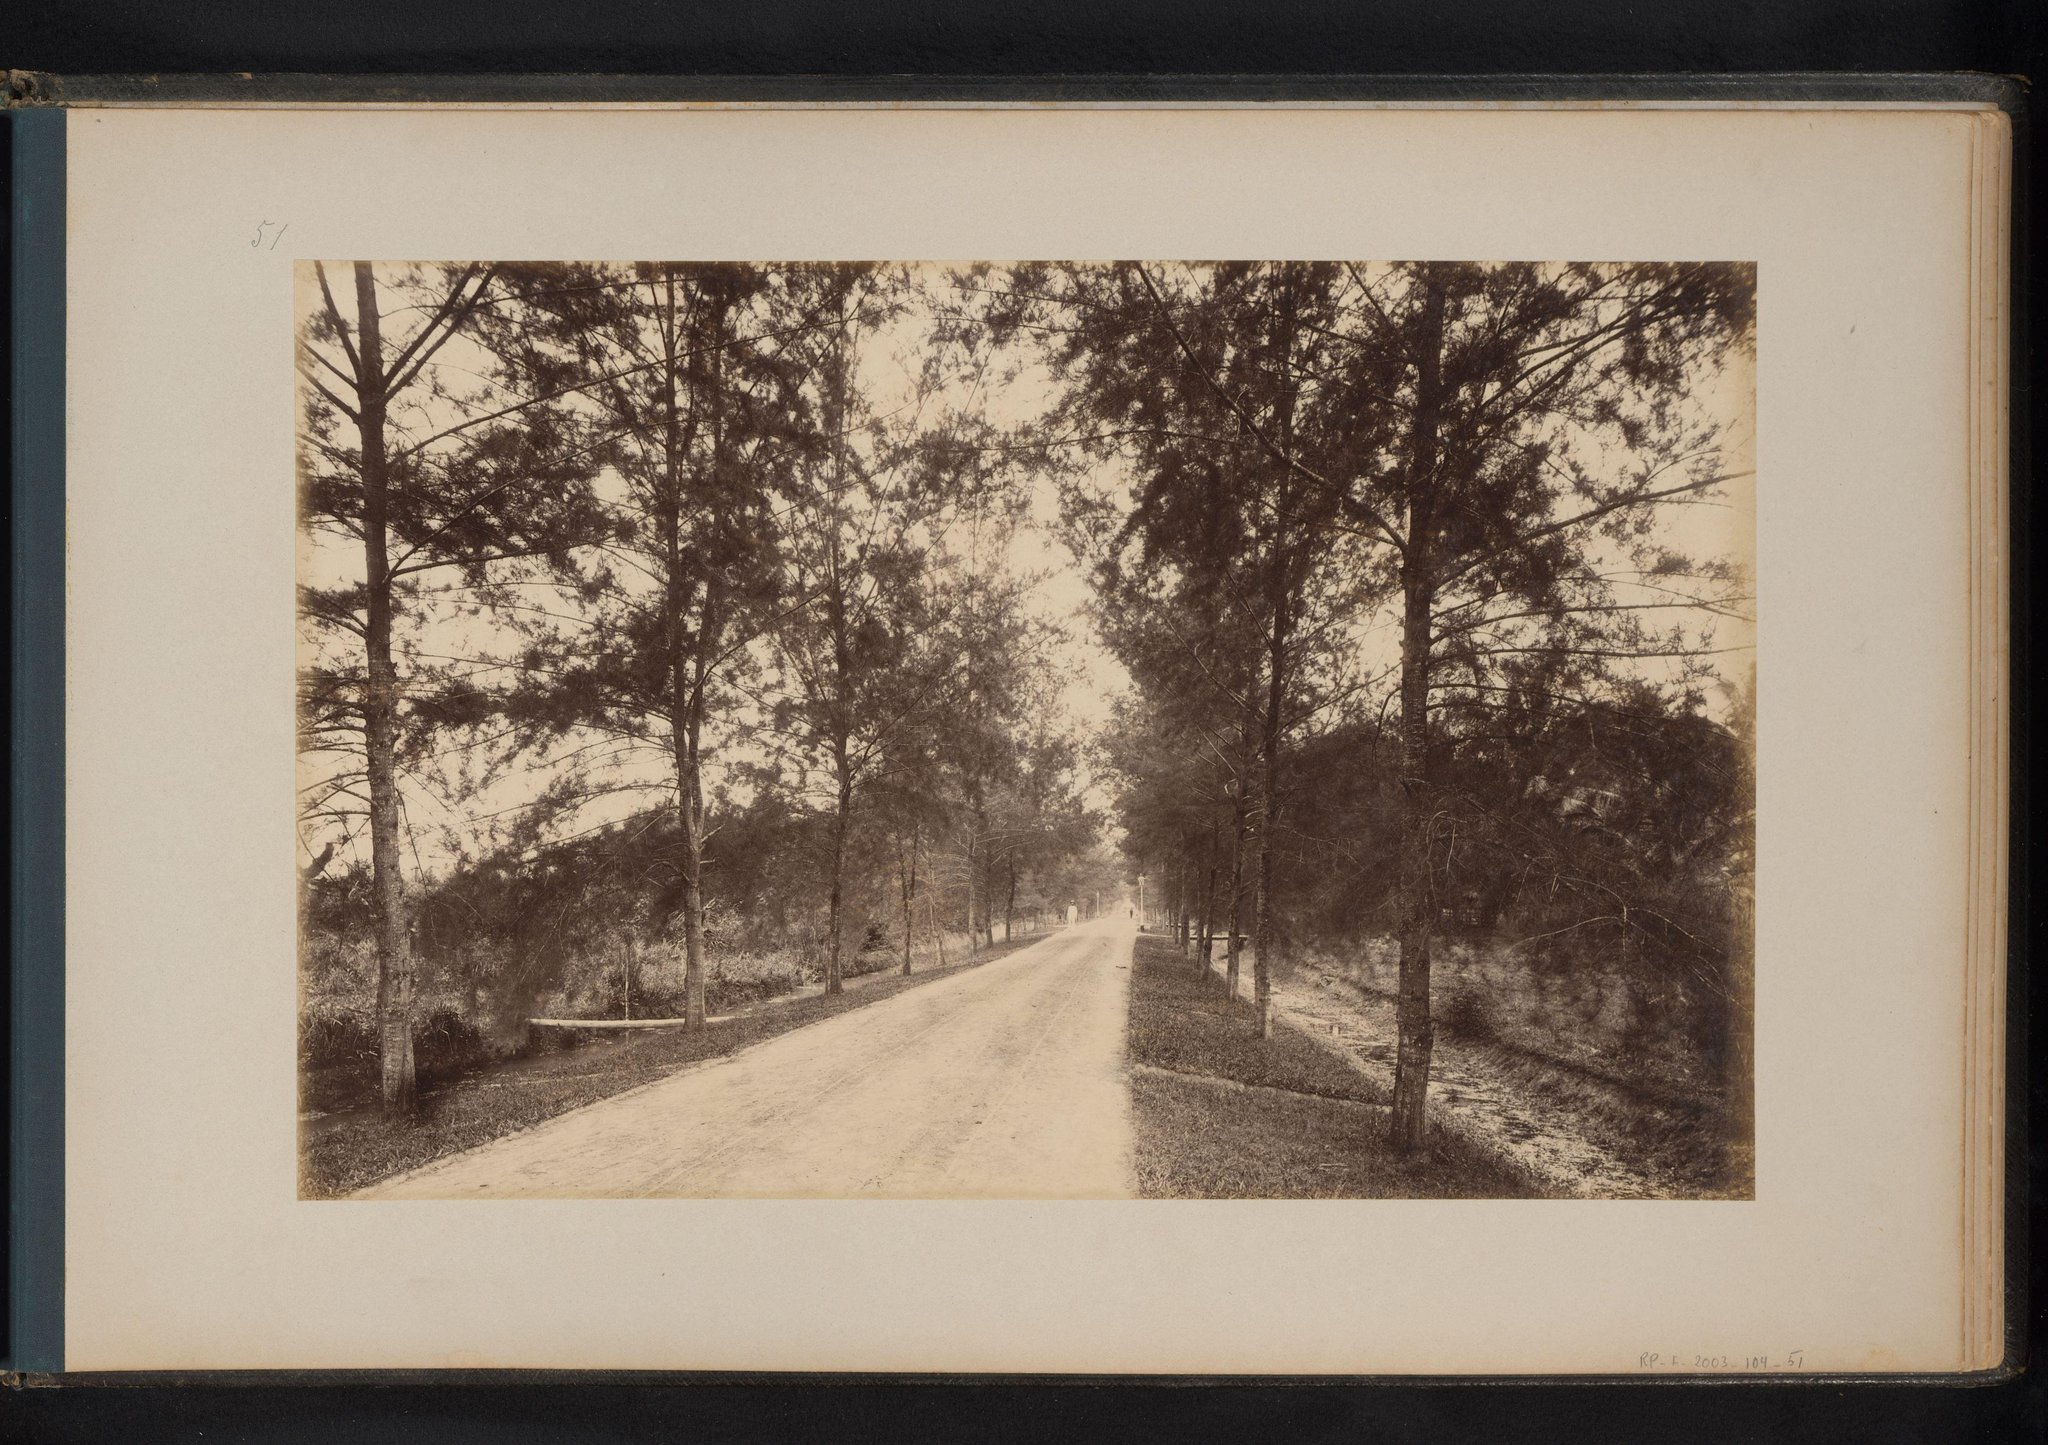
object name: album leaf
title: Laan met cemara bomen in Tandjong Poera, Sumatra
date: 1890-1900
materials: cardboard, photographic support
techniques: albumen print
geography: tandjong poera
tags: trees, road, path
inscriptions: number: ‘51’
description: In de lijst van afbeeldingen wordt deze foto beschreven met de woorden "Tjemara-Allee in Tandjong Poera".